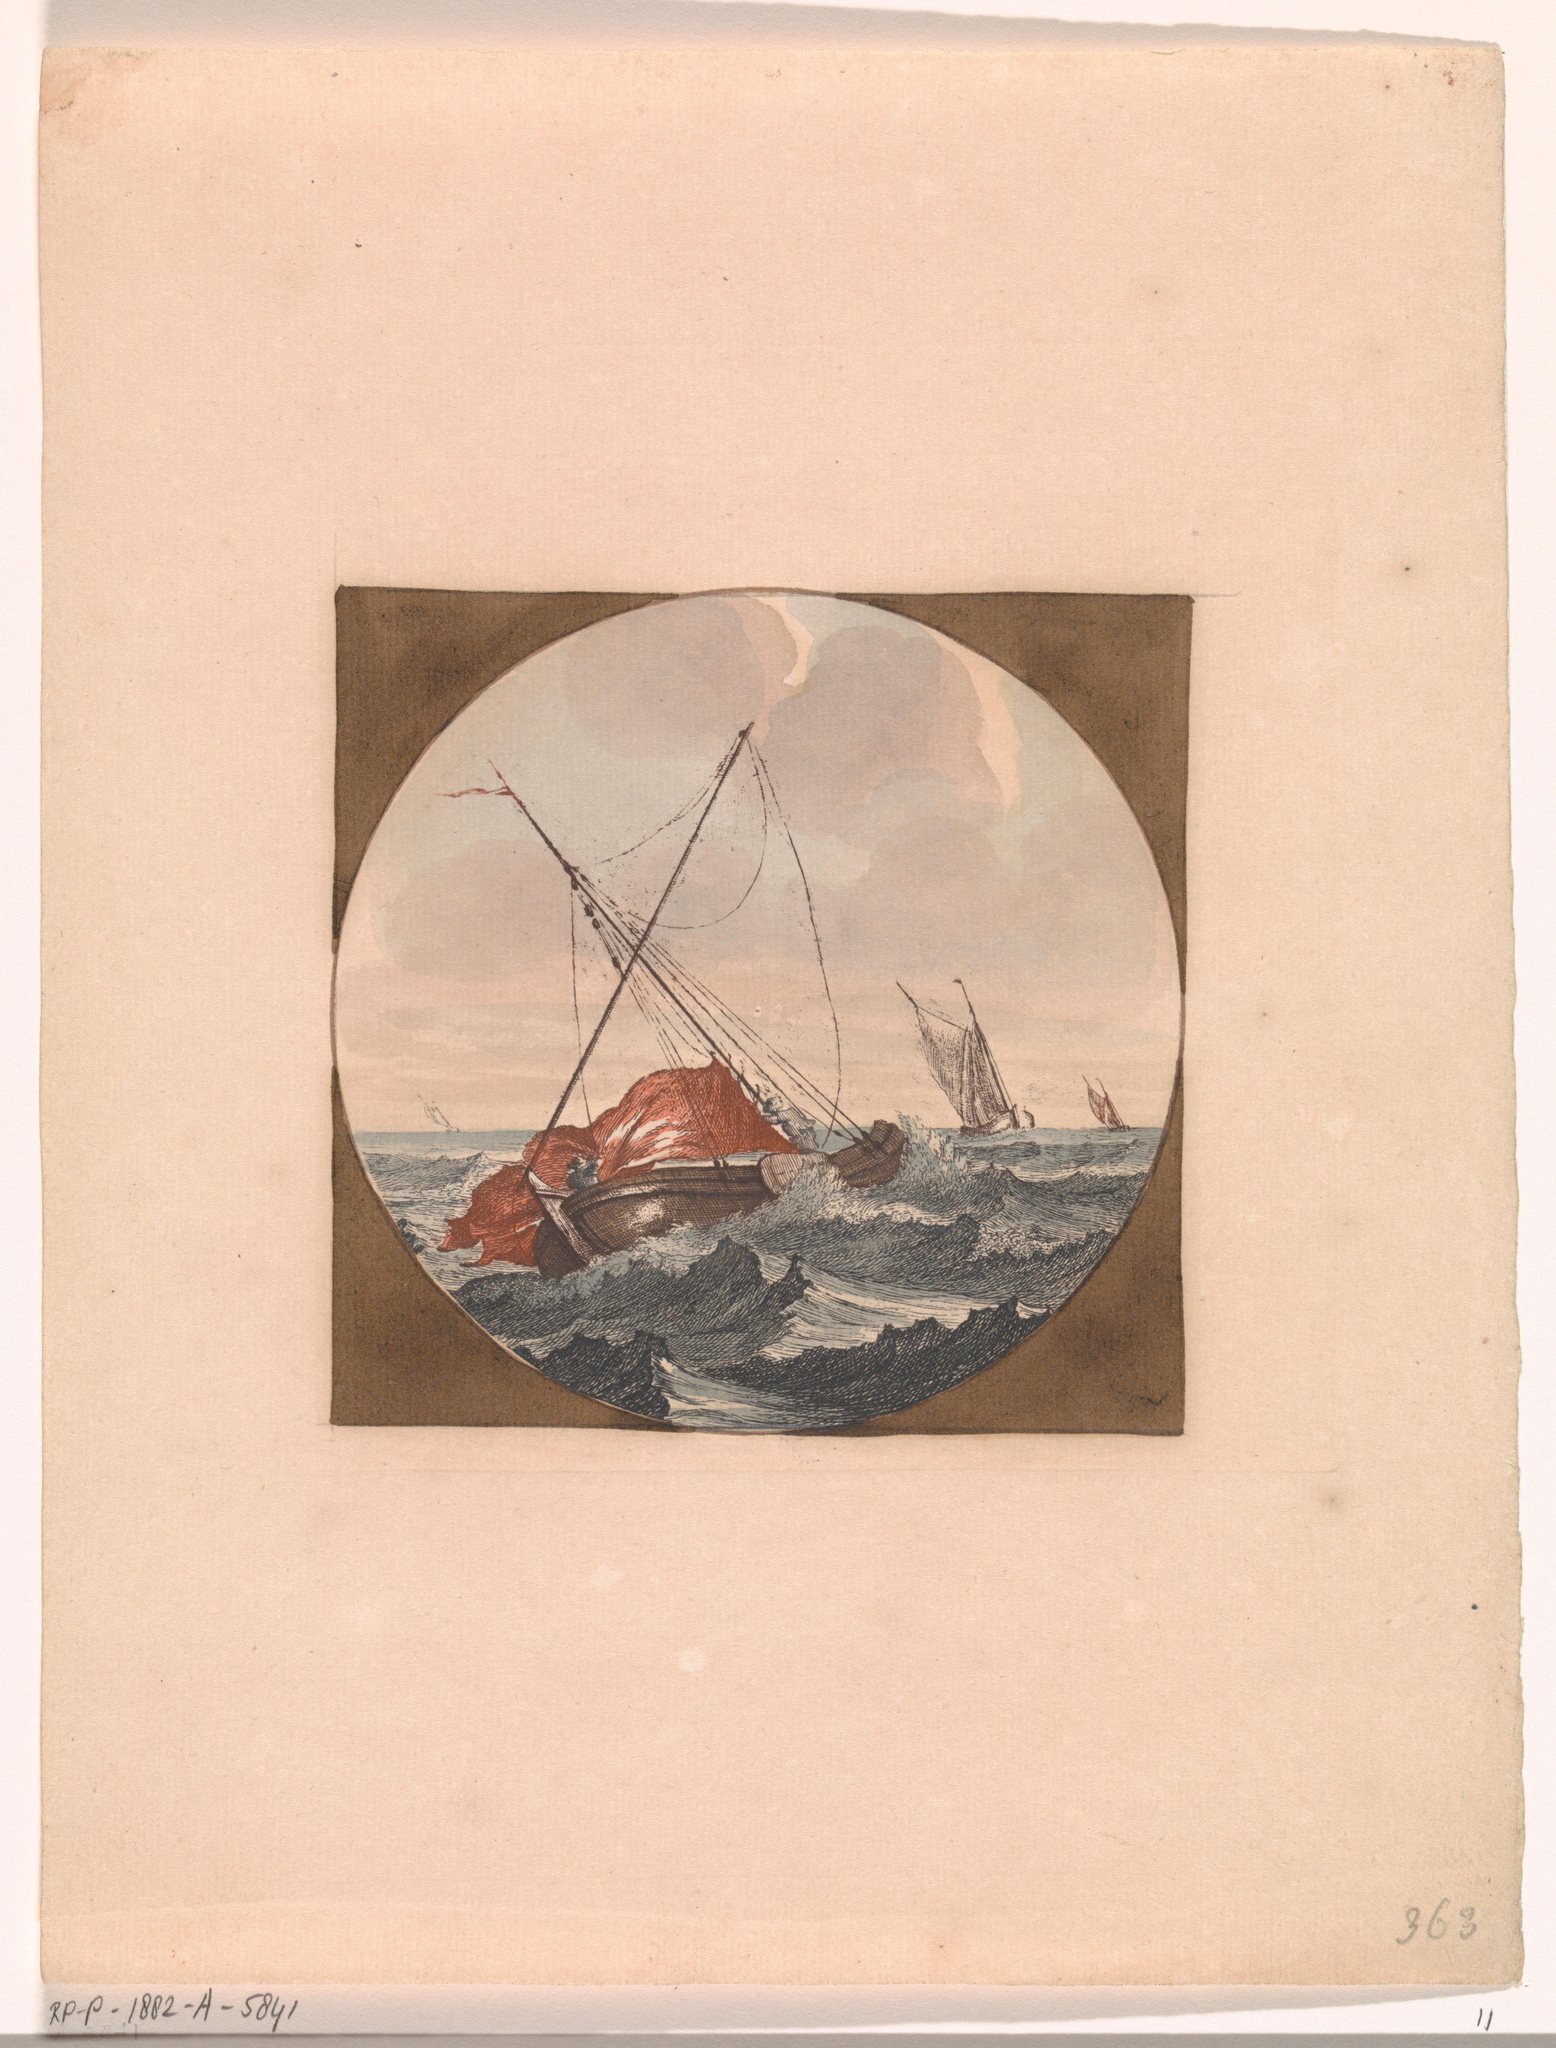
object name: print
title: Strijken van het zeil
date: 1688-1698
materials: paper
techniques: etching, hand coloring, lithography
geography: netherlands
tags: sailing-ship, sailing-boat, sea (seascape)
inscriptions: collector's mark: Lugt 2228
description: Twee mannen strijken het zeil van een platbodem. Op de achtergrond andere zeilschepen.